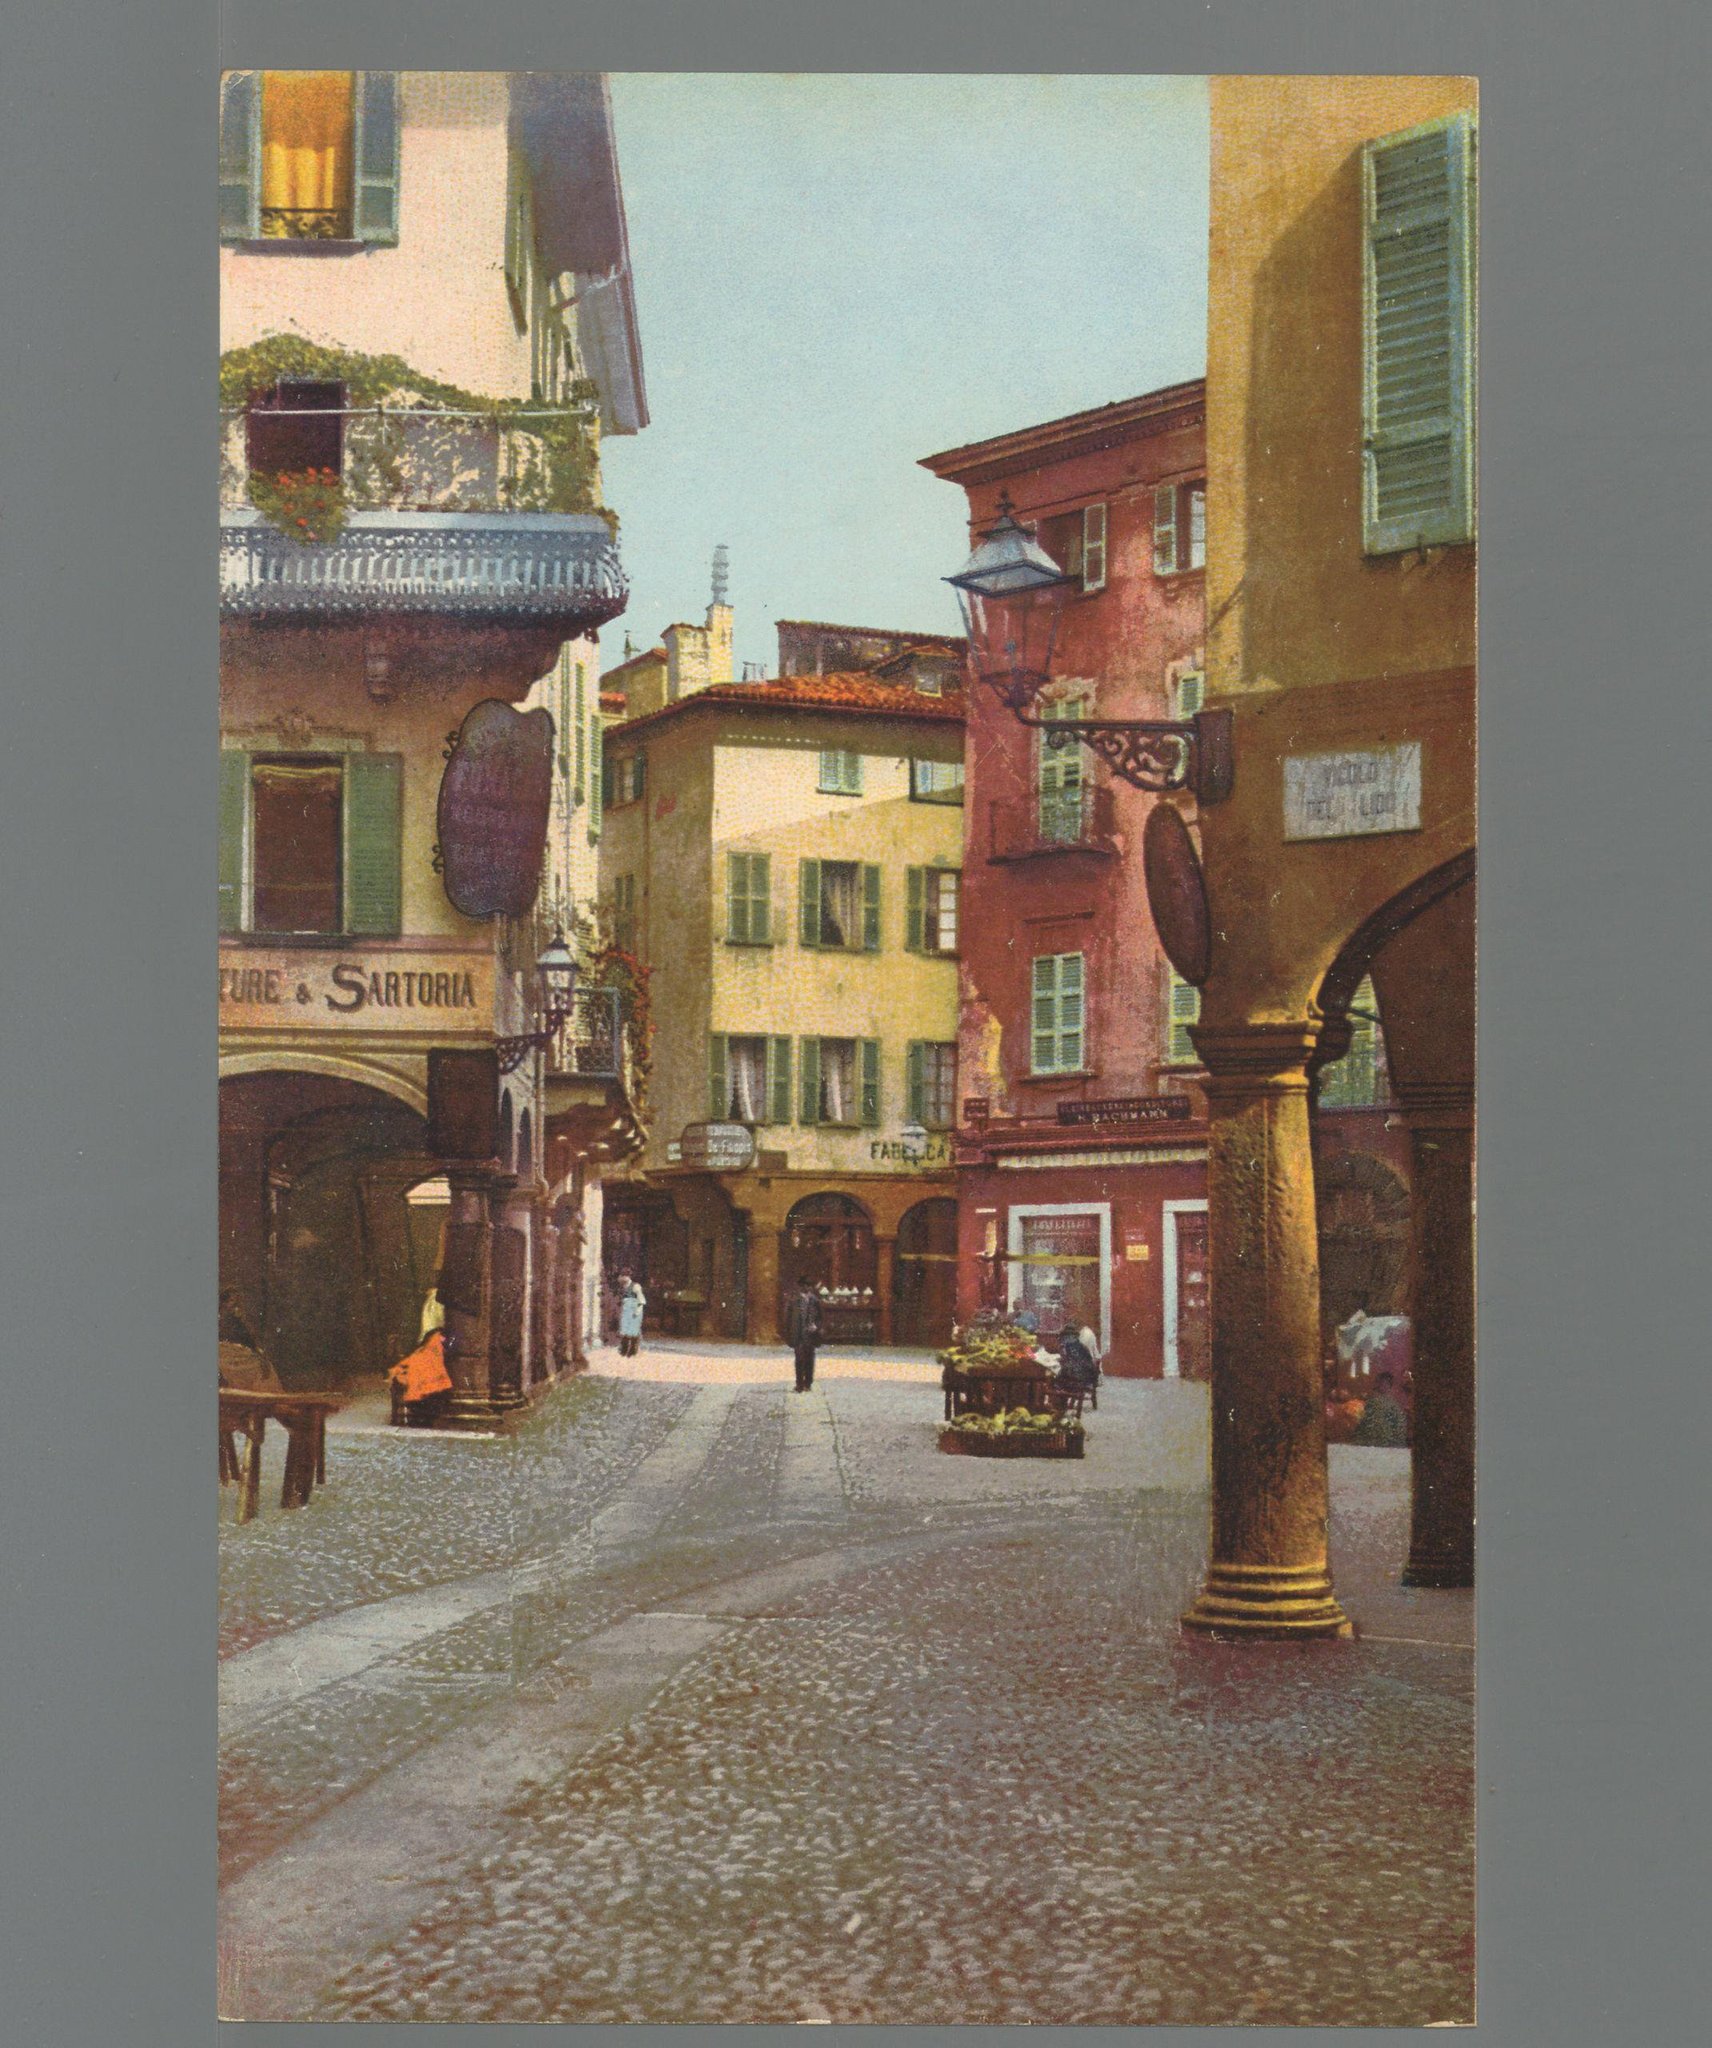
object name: photomechanical print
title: Lugano. Piazza Commercio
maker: Anonymous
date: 1905-1920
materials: cardboard, photographic process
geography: lugano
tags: arcade ~ architecture, street (+ city(-scape) with figures, staffage)